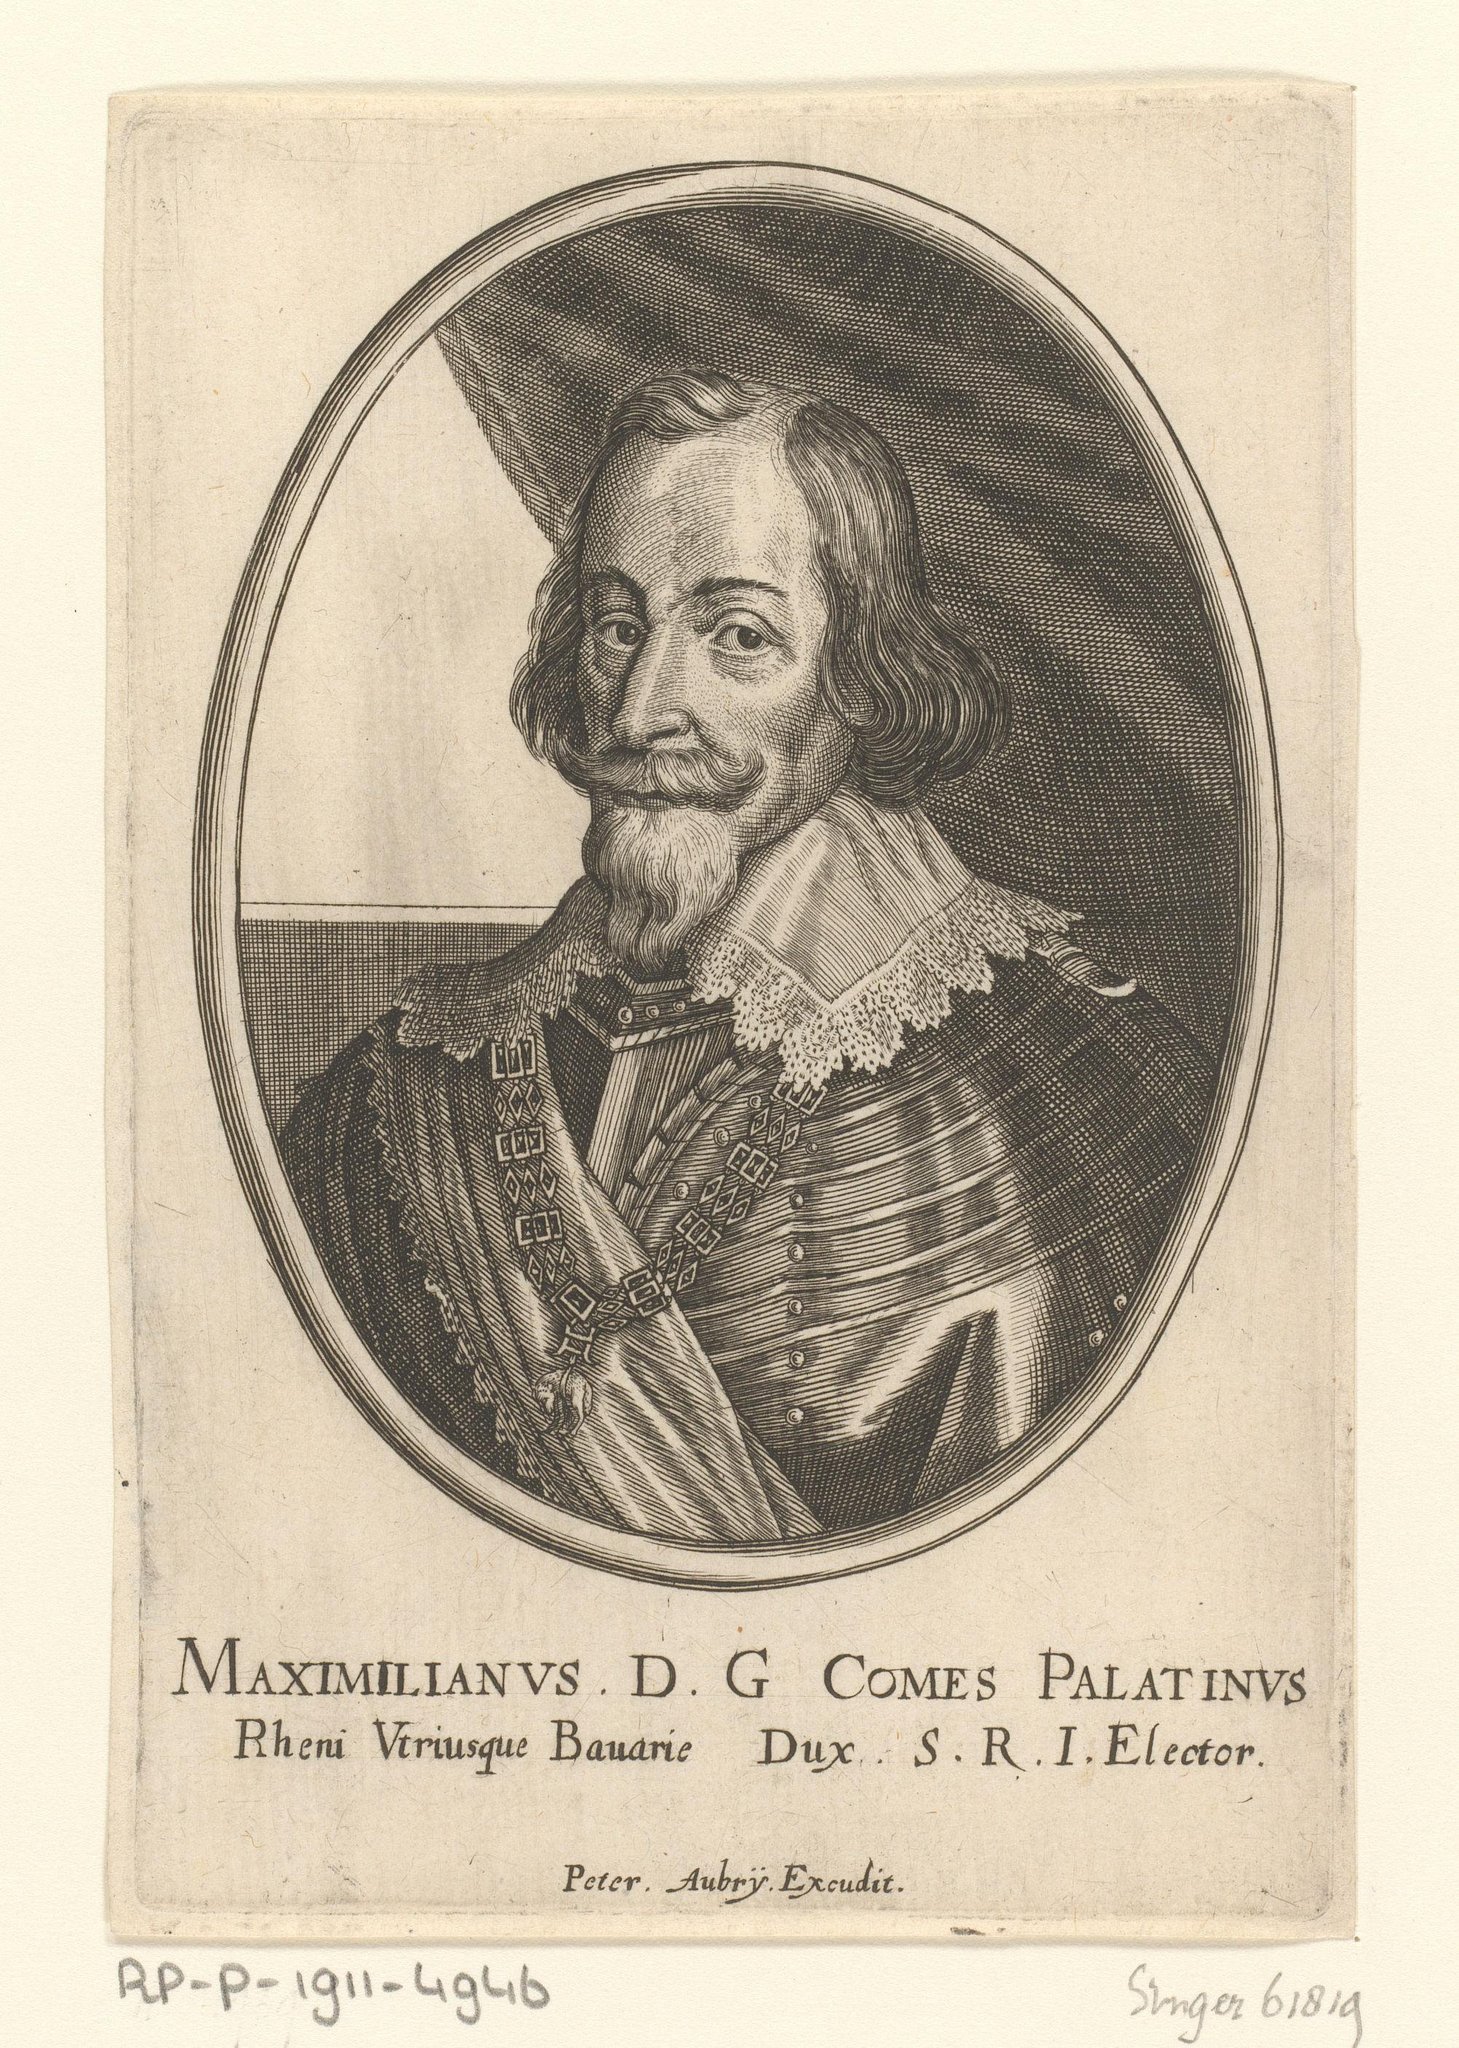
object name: print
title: Portret van Maximiliaan I van Beieren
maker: Anonymous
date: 1623-1686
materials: paper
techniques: engraving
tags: maximiliaan i (keurvorst van beieren), historical persons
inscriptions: collector's mark: Lugt 2228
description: Met tweeregelig onderschrift in het Latijn.